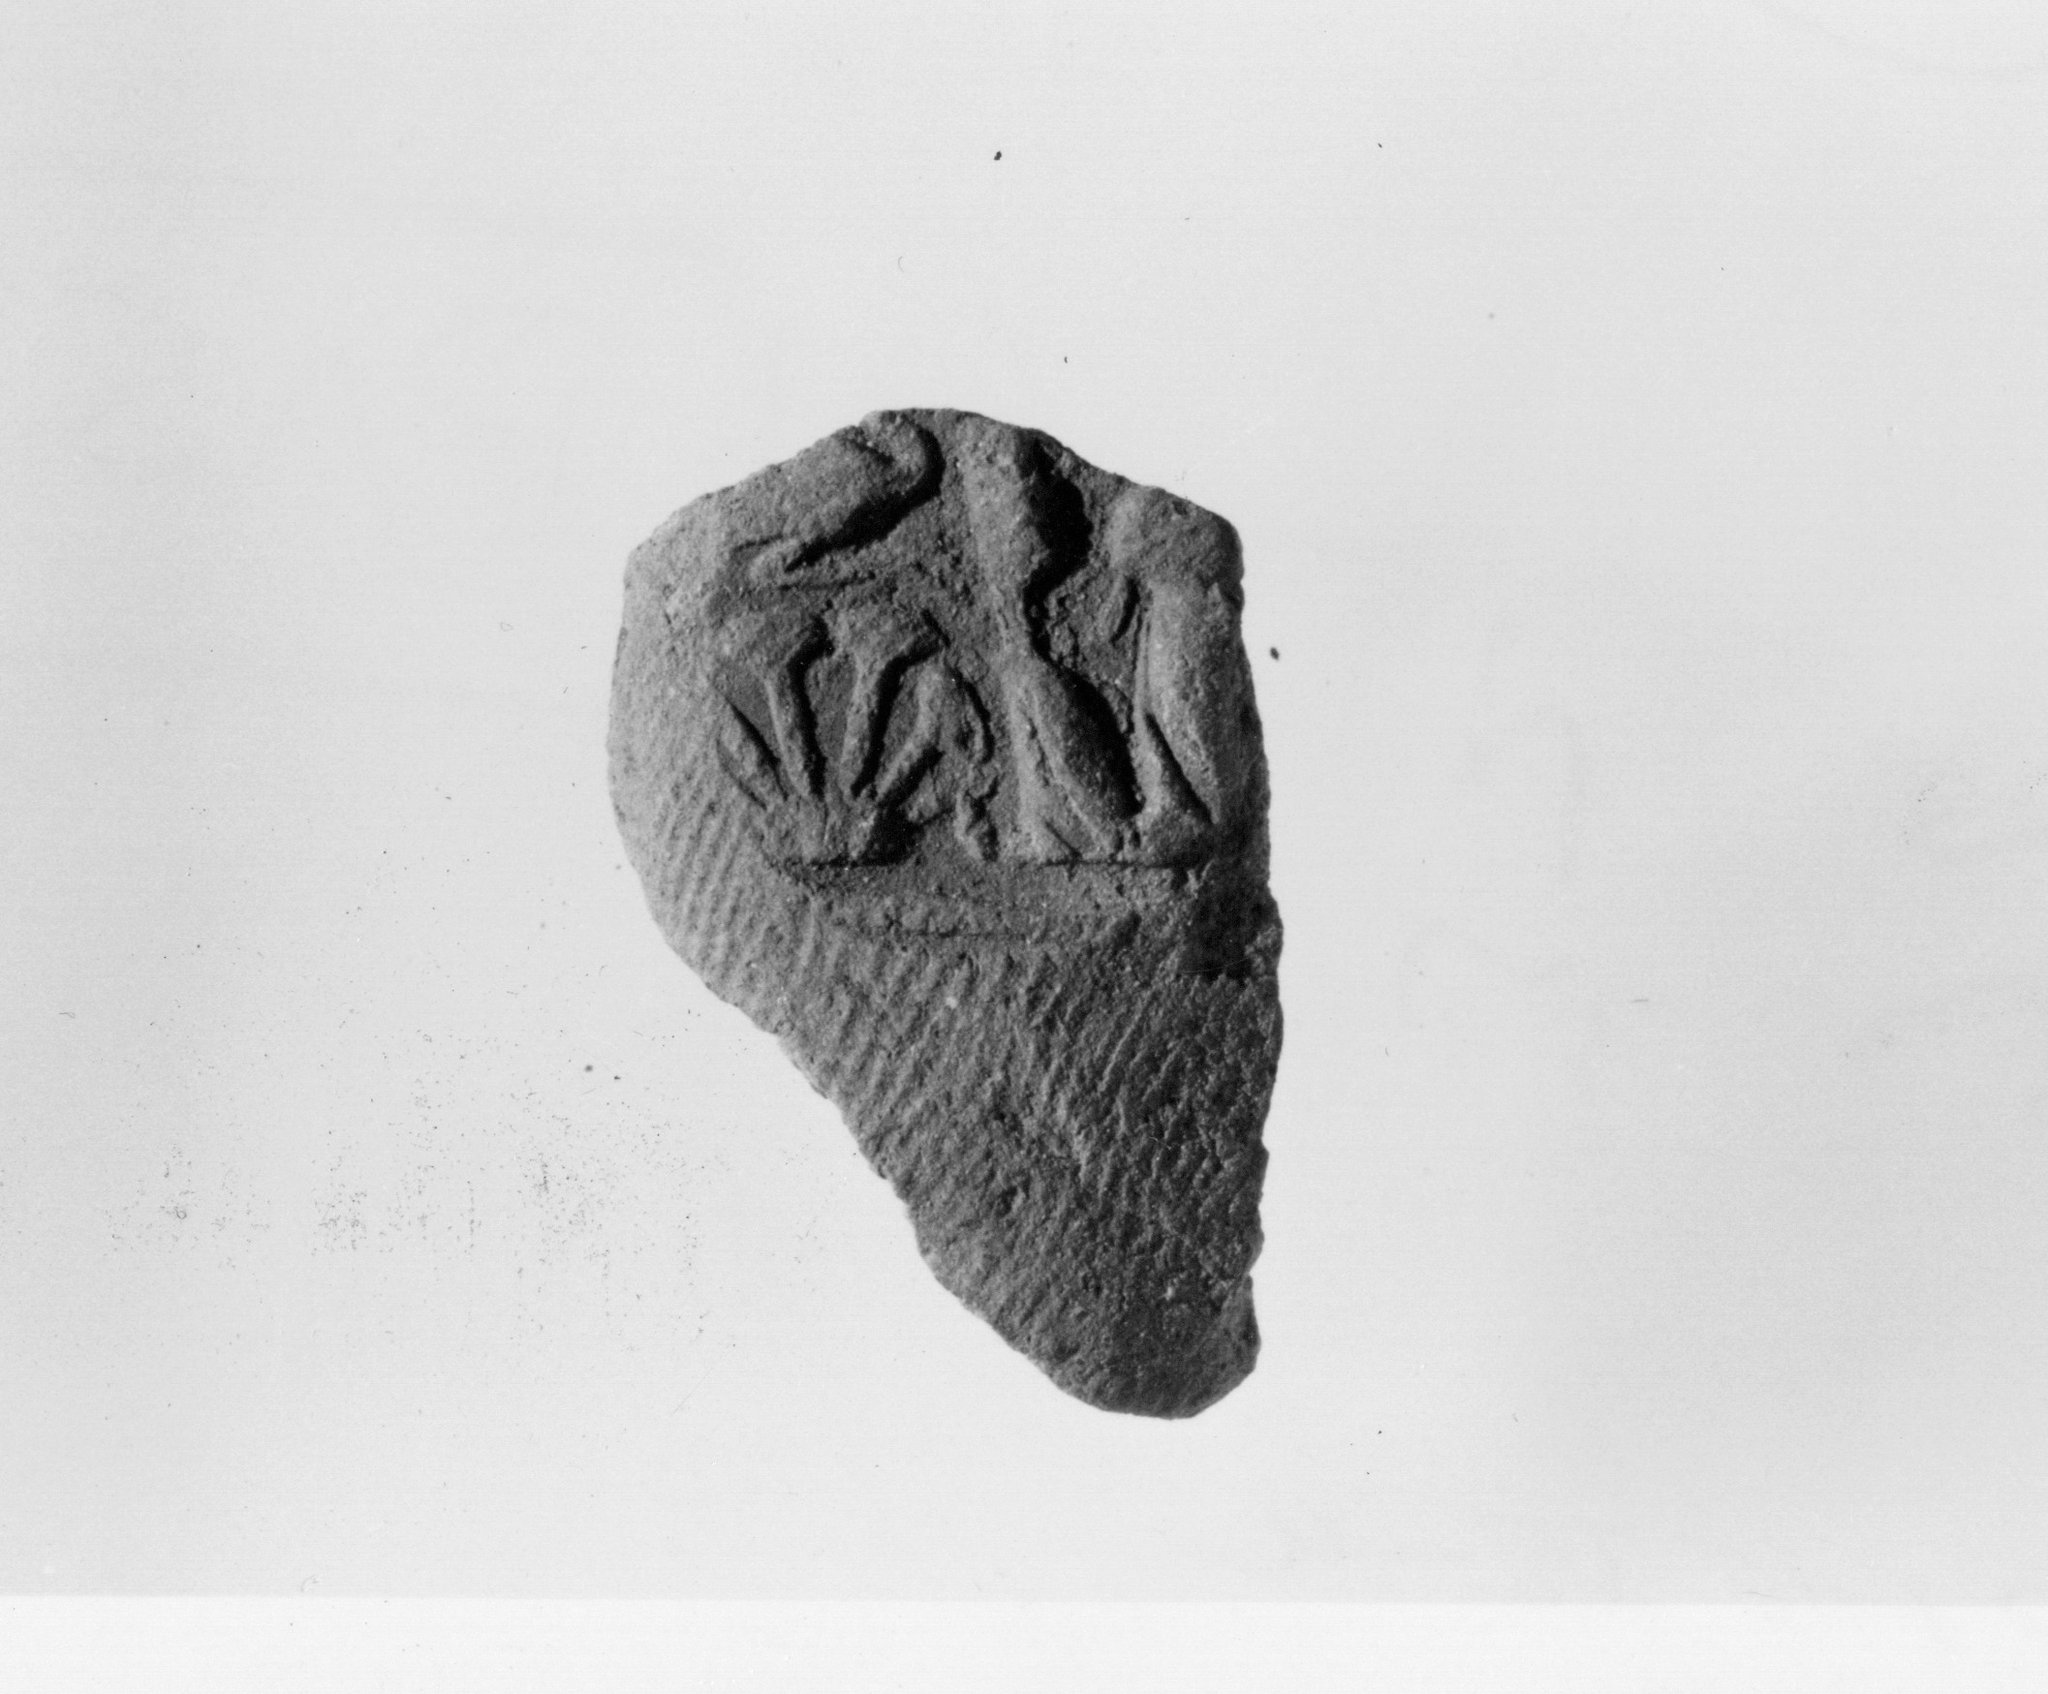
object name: sealing, nebmaatre, amenhotep iii, lower egypt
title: Document Sealing With the Throne Name of Amenhotep III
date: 1390-1352 BCE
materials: mud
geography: egypt